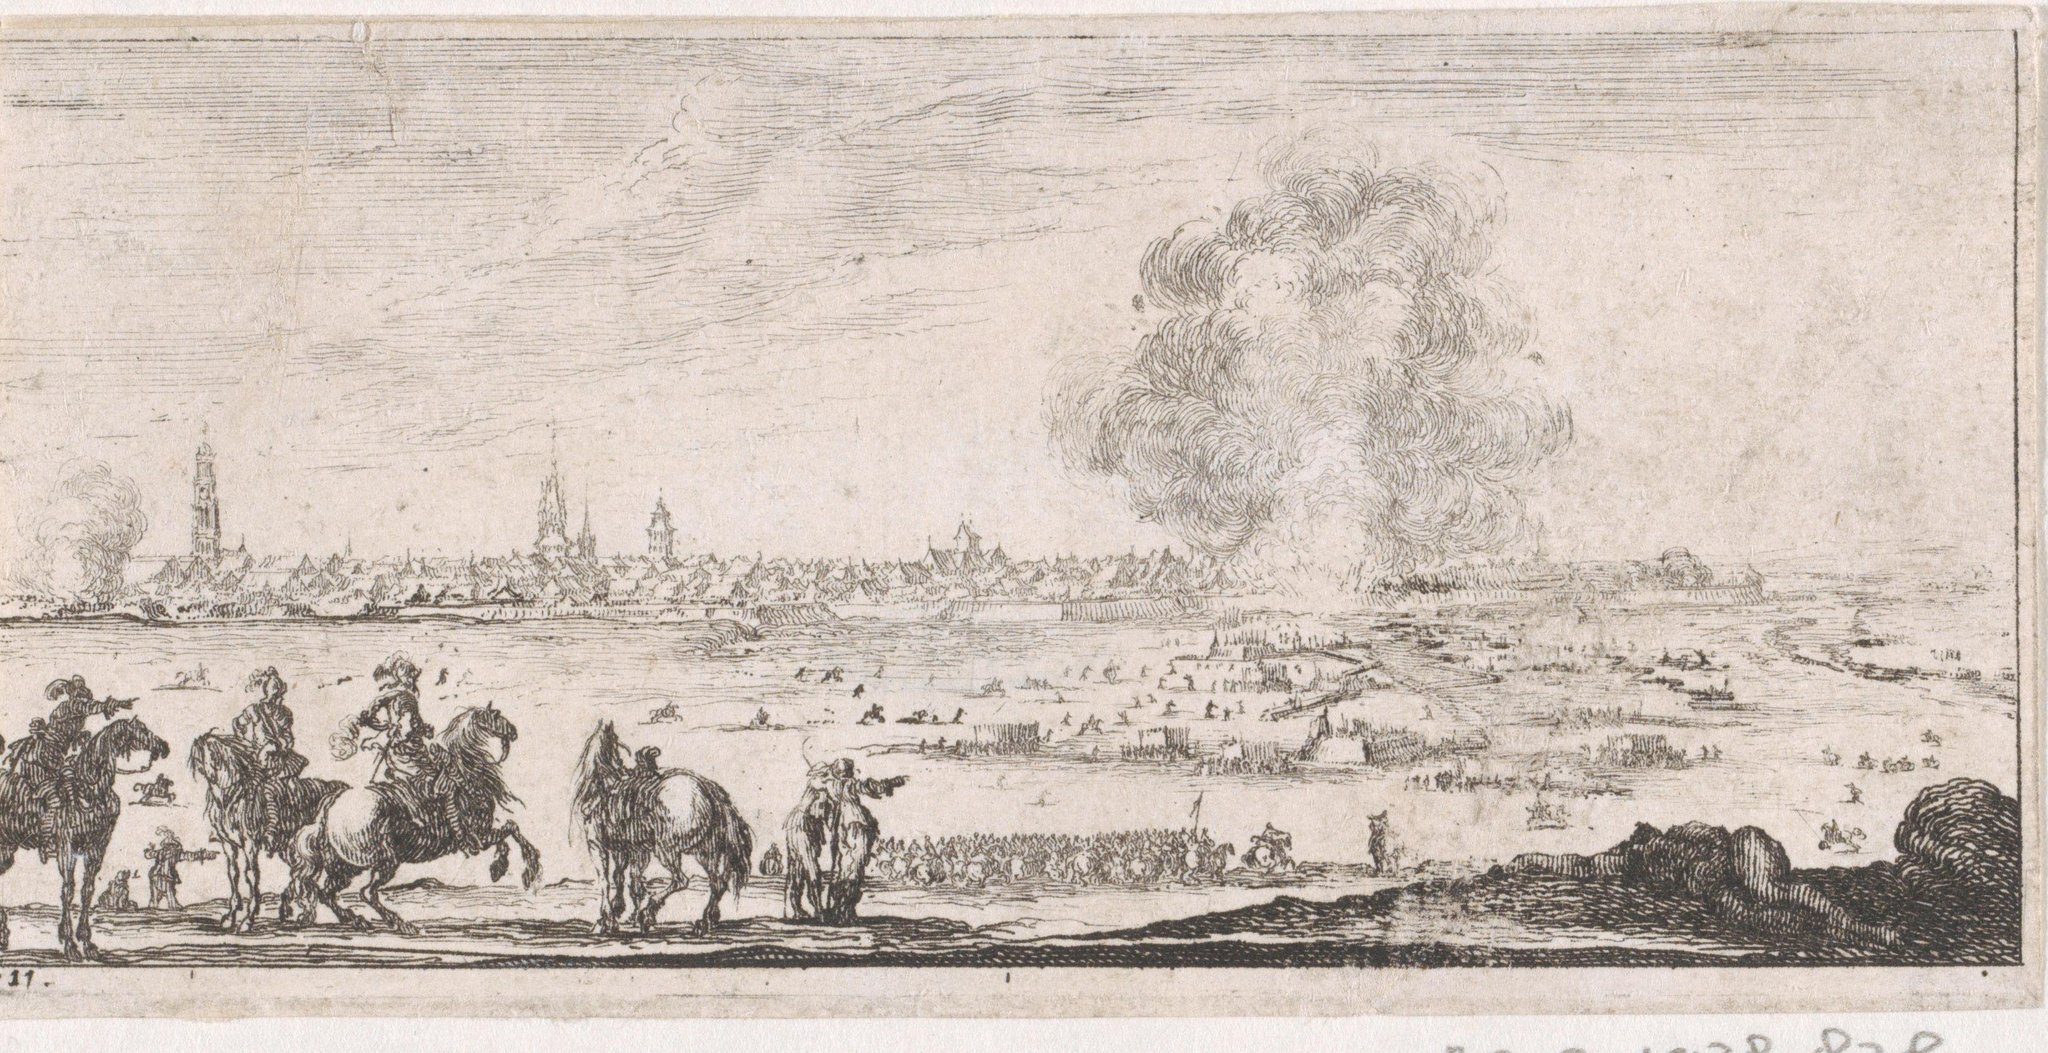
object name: print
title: Aanval op Arras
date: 1620-1664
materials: paper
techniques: etching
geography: france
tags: city-view in general; 'veduta', warfare; military affairs (+ cavalry, horsemen), (military) attack, the soldier; the soldier's life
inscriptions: collector's mark: Lugt 2228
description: Op de voorgrond soldaten te paard die uitkijken over een vlakte. Op de achtergrond de zojuist aangevallen stad Arras (Atrecht) waarboven een grote rookwolk hangt.